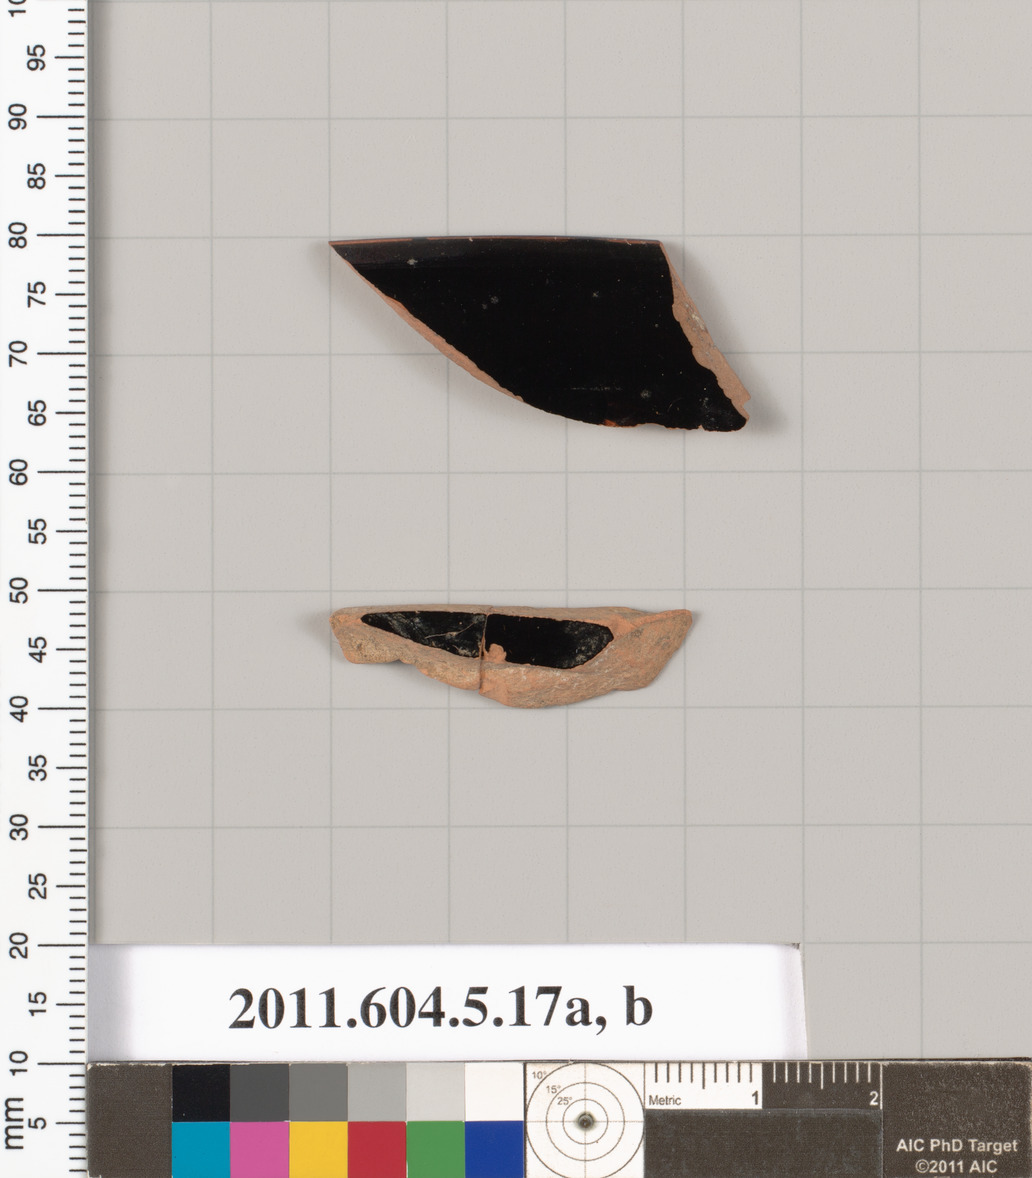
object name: kylix fragment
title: Terracotta fragments of kylikes (drinking cups)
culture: greek, attic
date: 500-480 BCE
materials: terracotta